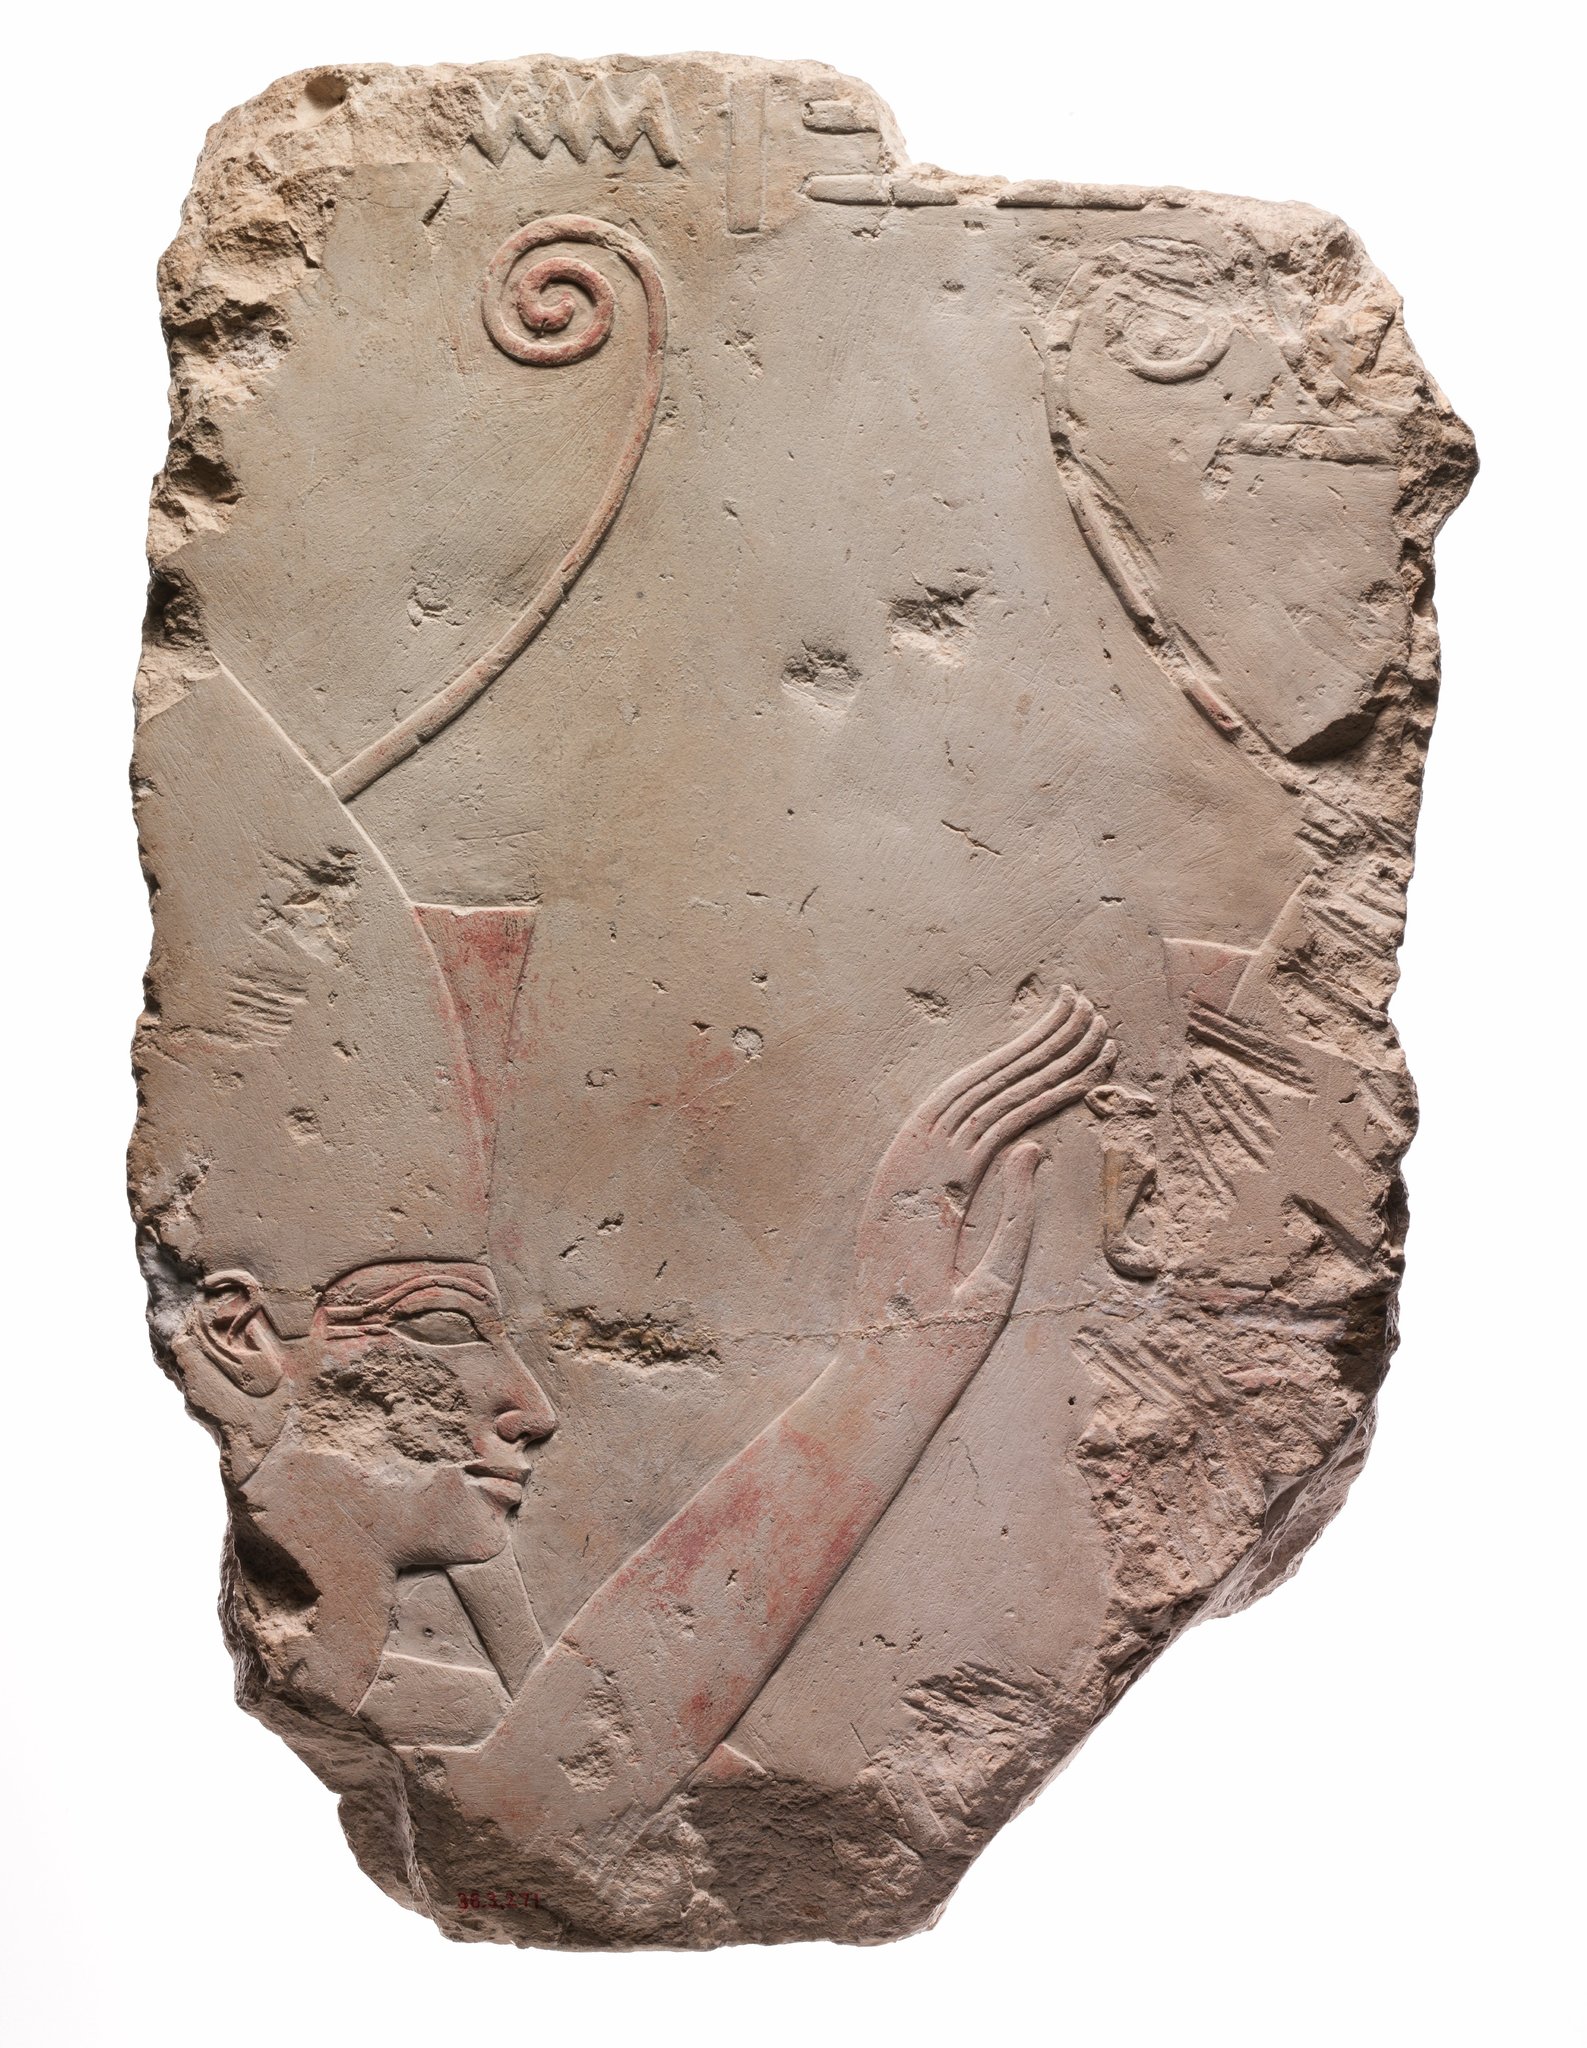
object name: relief, atum, hatshepsut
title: Relief Fragment Depicting Atum and Hatshepsut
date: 1479-1458 BCE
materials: limestone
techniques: painting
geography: egypt